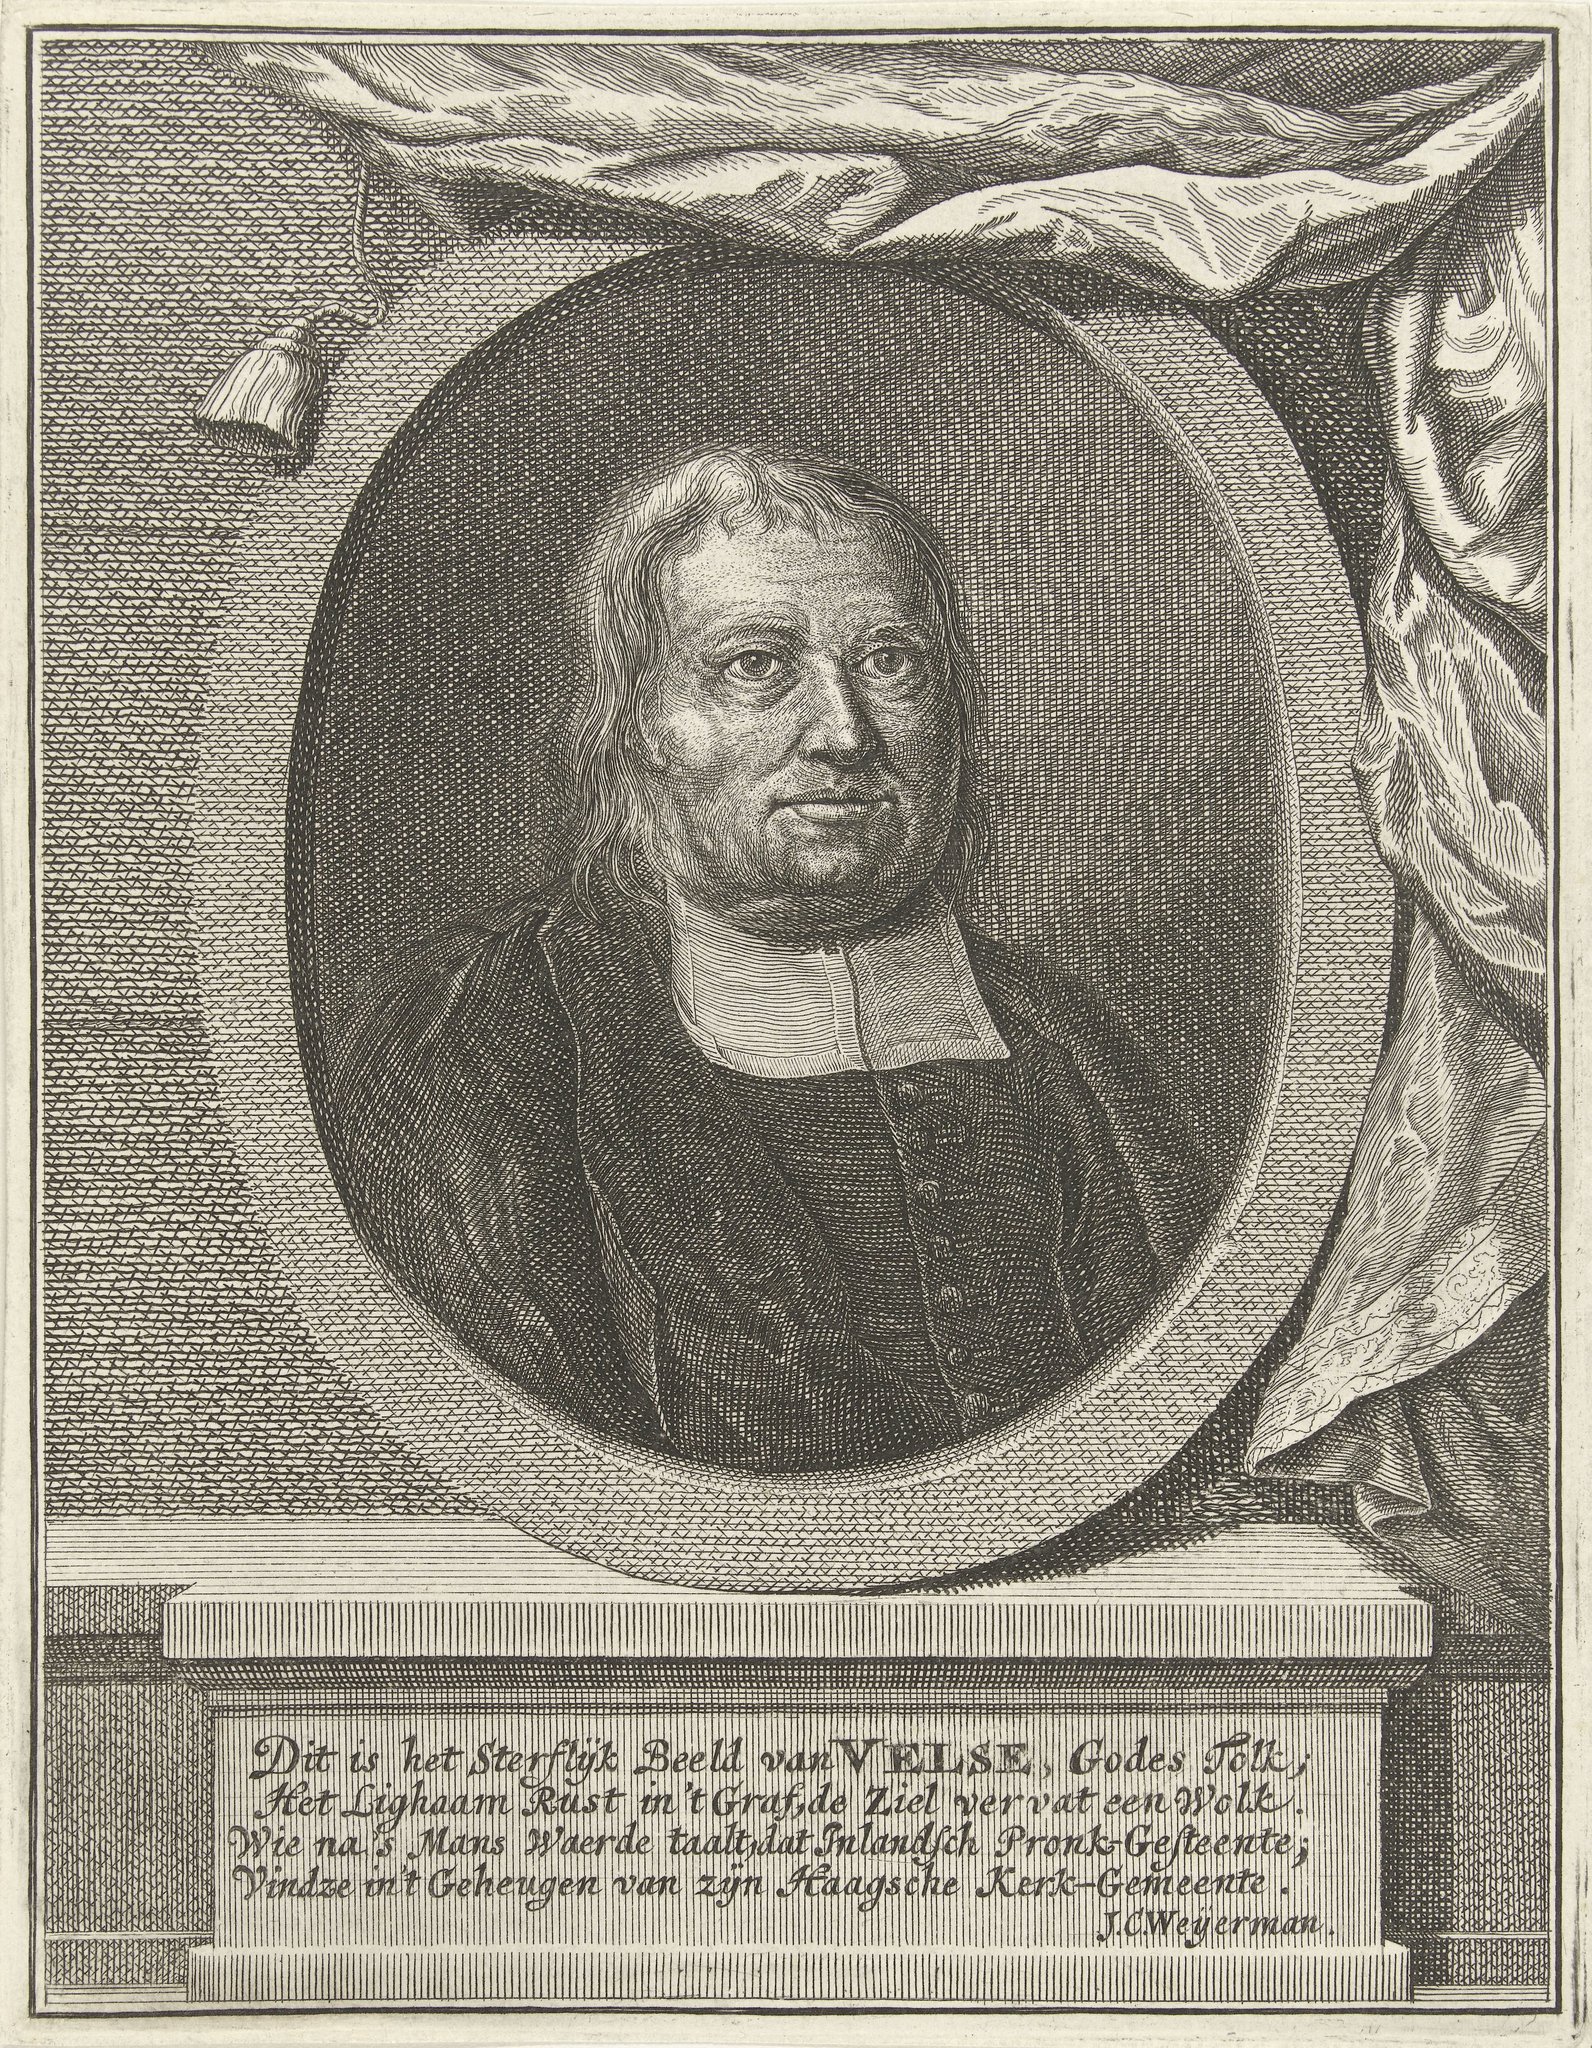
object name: print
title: Portret van Henricus Velsen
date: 1744-1765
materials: paper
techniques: etching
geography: the hague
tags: the hague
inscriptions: collector's mark: Lugt 2228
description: Portret in ovale lijst van de Haagse predikant Henricus Velsen. Buste naar links. De prent heeft een Nederlands grafschrift op rijm.